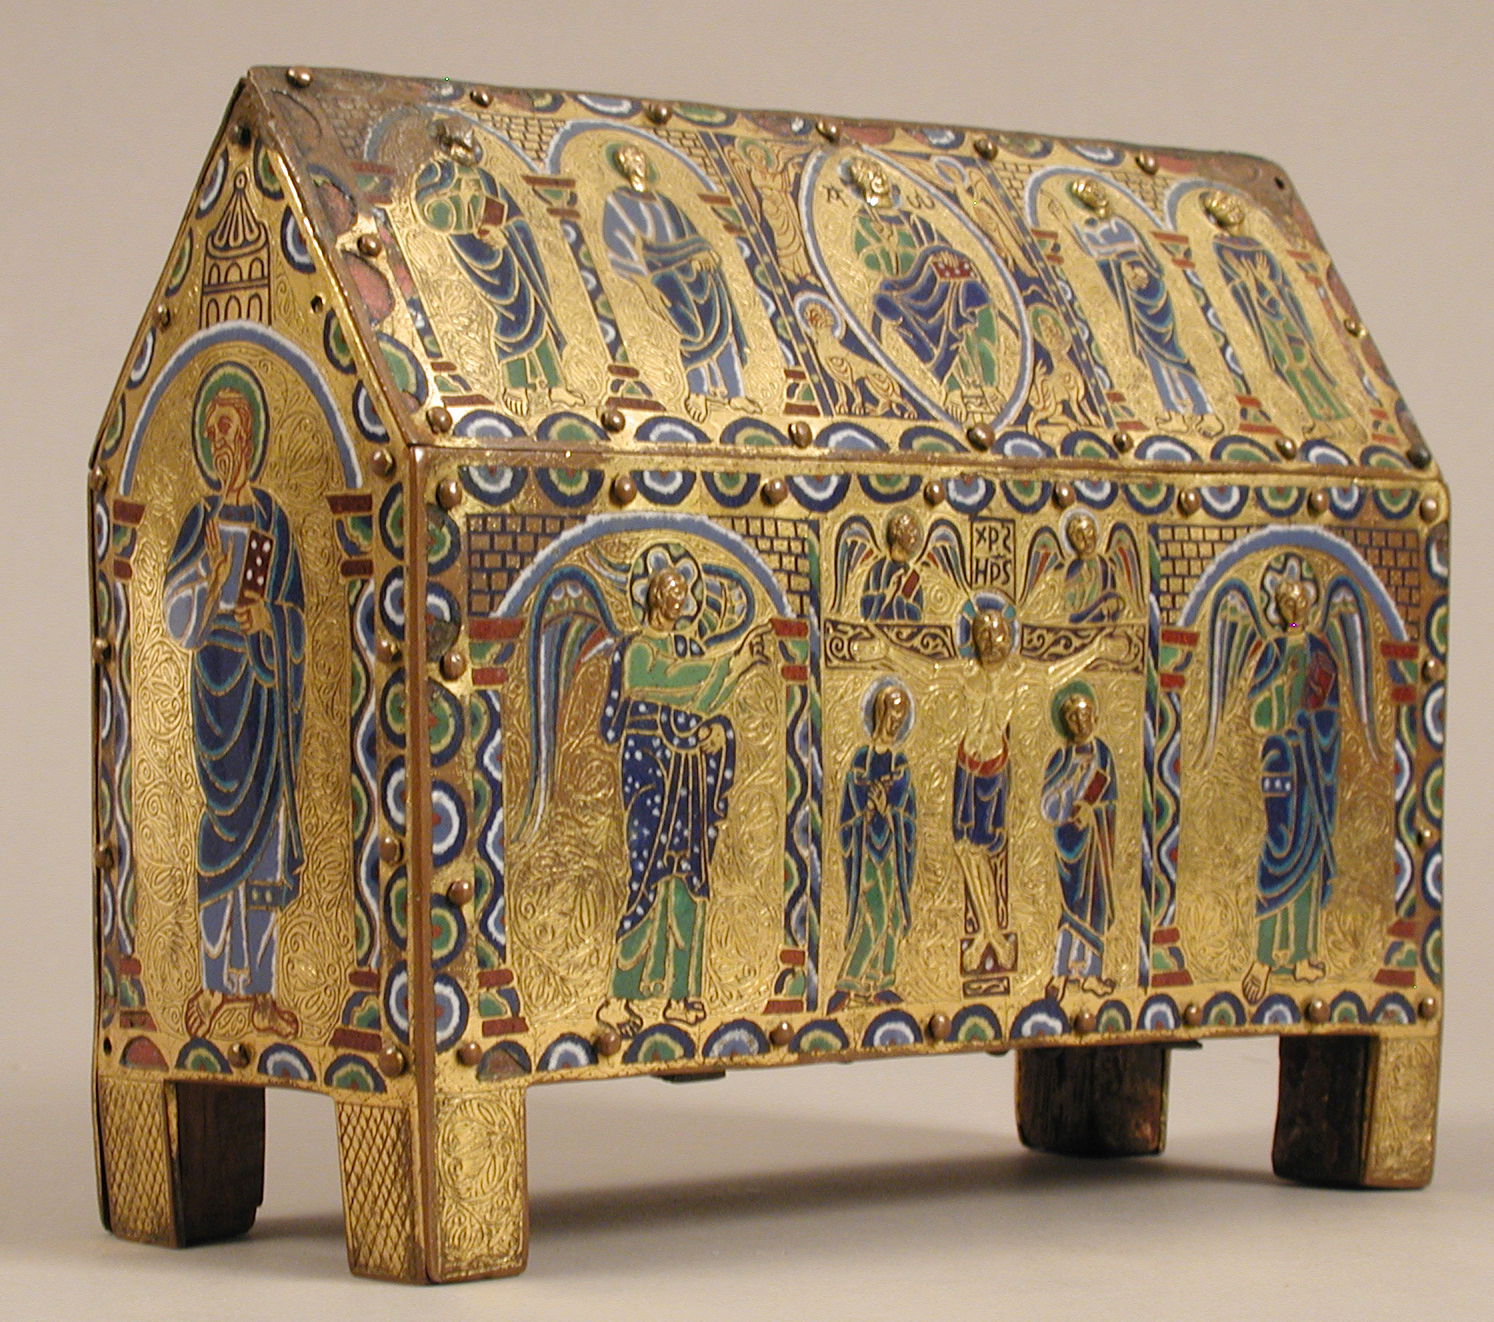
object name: chasse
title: Chasse with The Crucifixion and Christ in Majesty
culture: french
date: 1190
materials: copper, enamel, gilt, wood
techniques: enamel, engraving, painting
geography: france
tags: angels,apostles,jesus,crucifixion